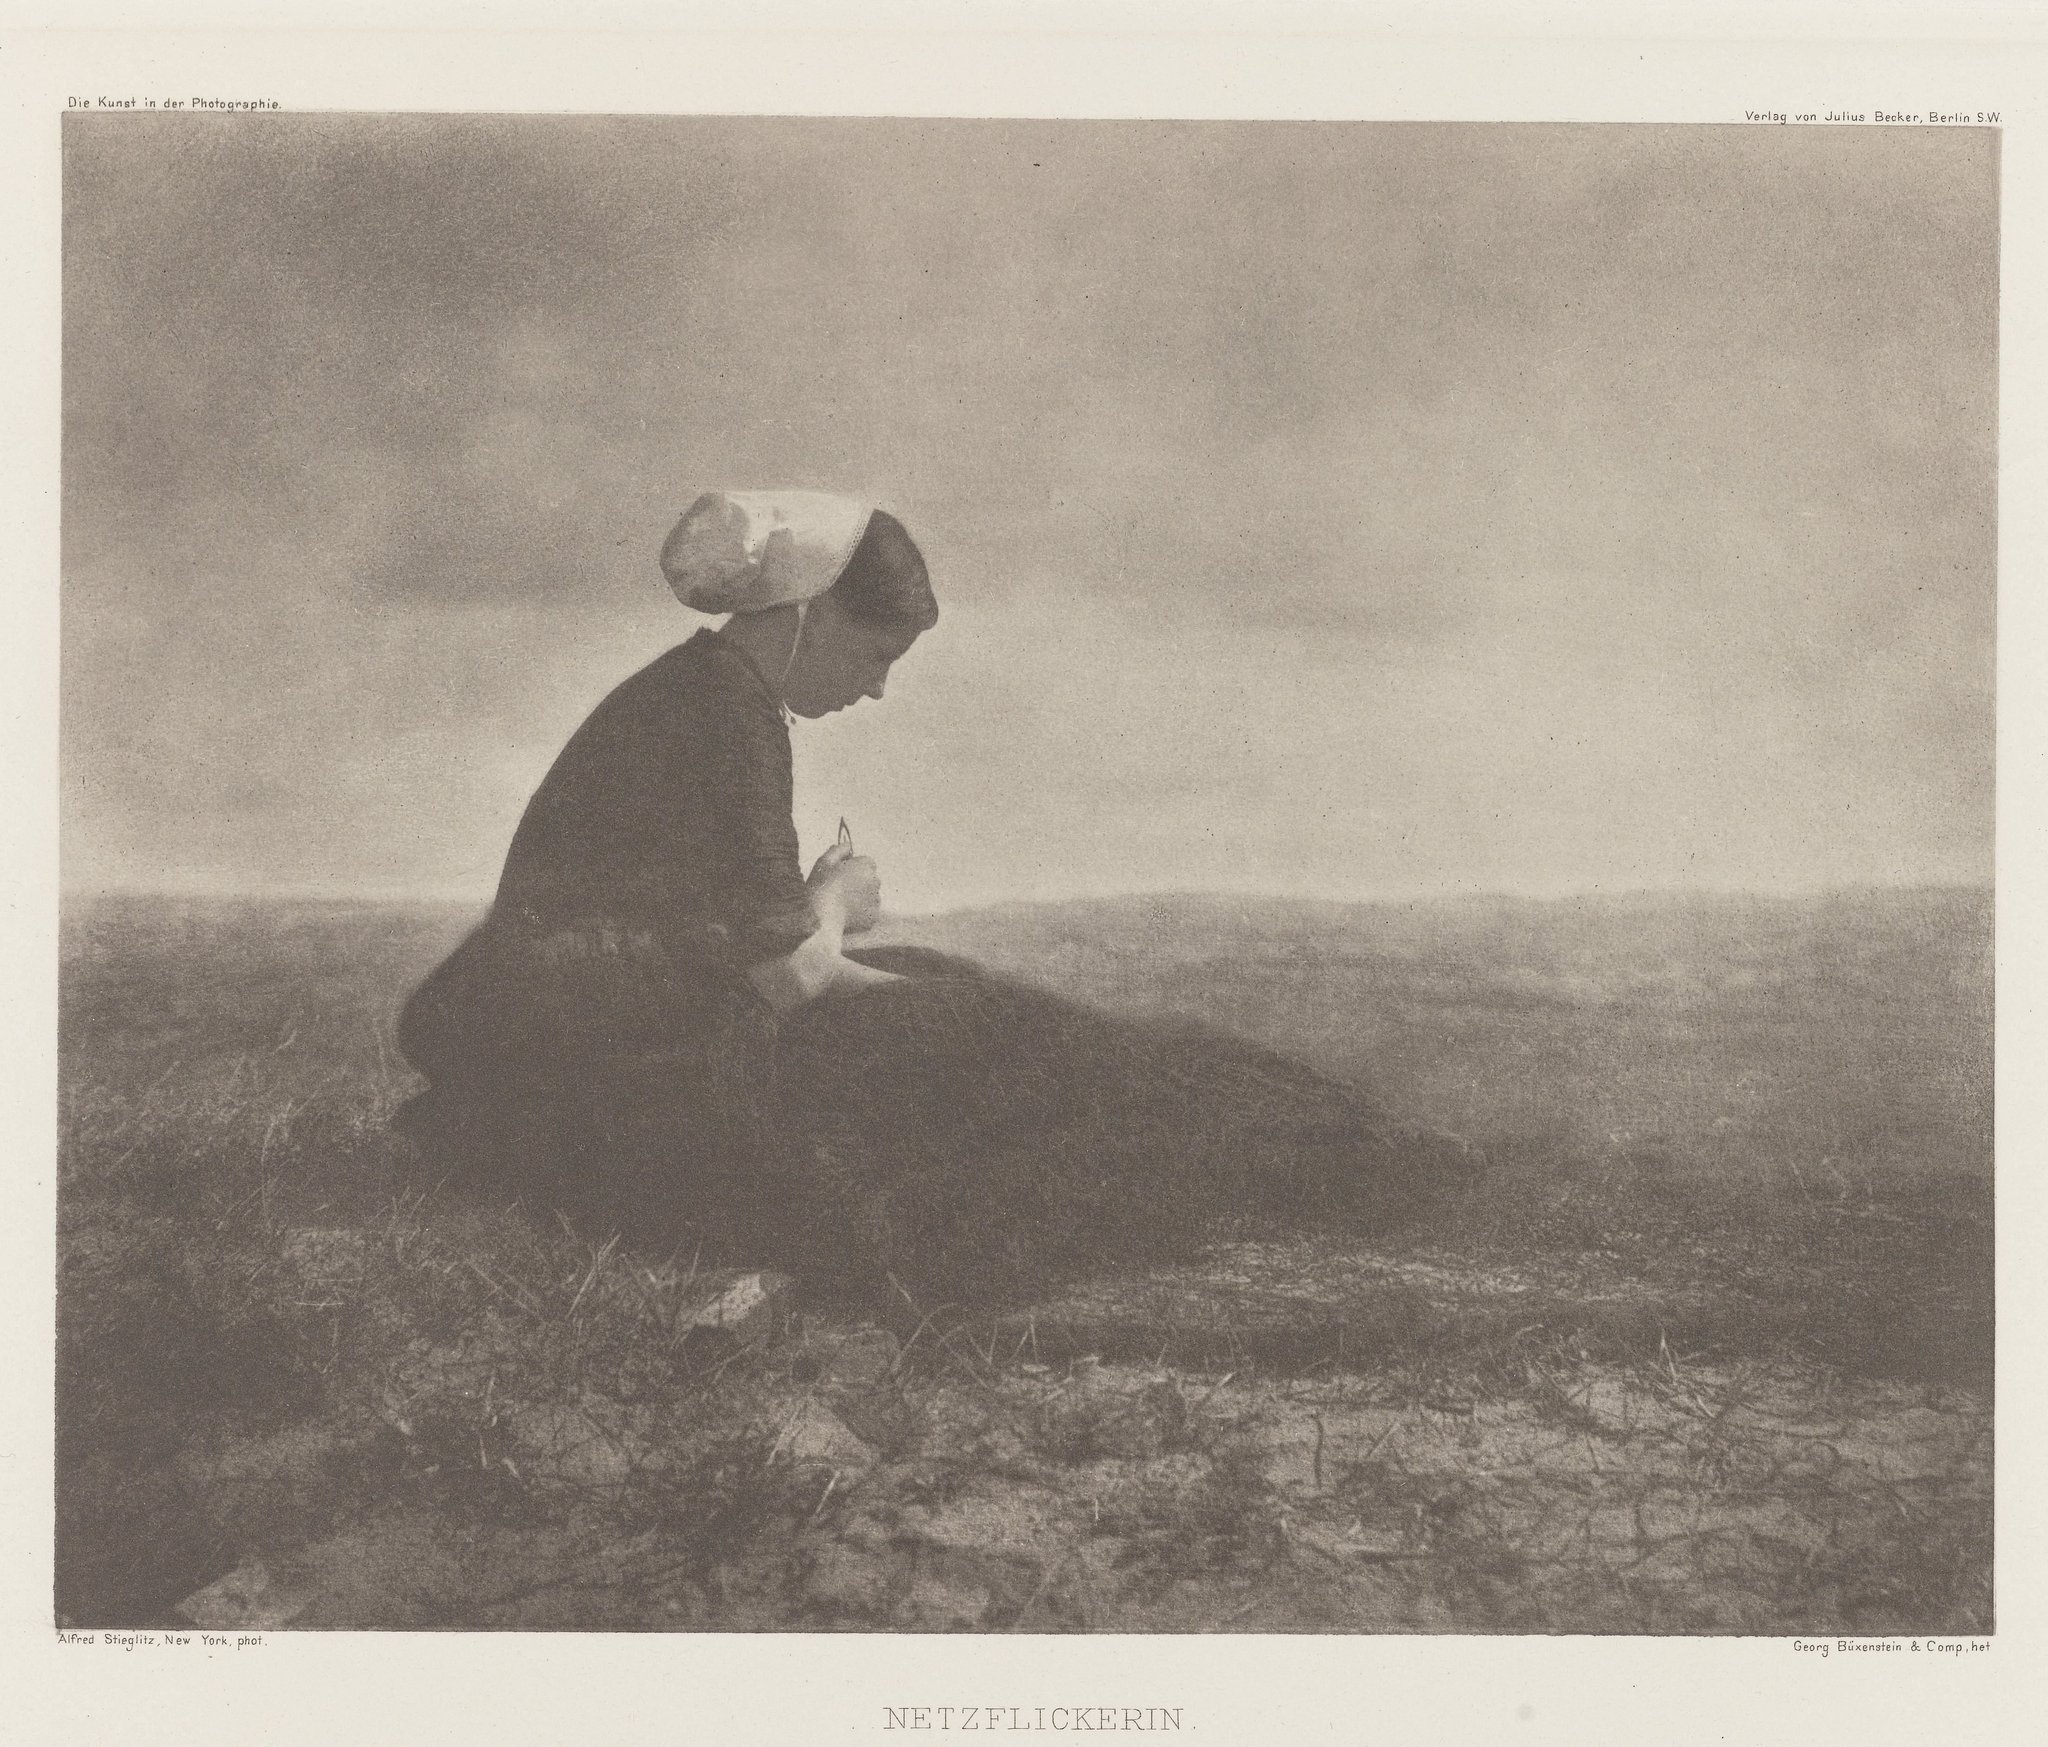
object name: photograph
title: Netzflickerin (Mending Nets), Katwijk 1894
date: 1894-1898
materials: ink, paper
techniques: photoaquatint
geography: berlin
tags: katwijk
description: Foto komt uit Die Kunst in der Photographie jrg. 2 (1898) 1, pl. 5.